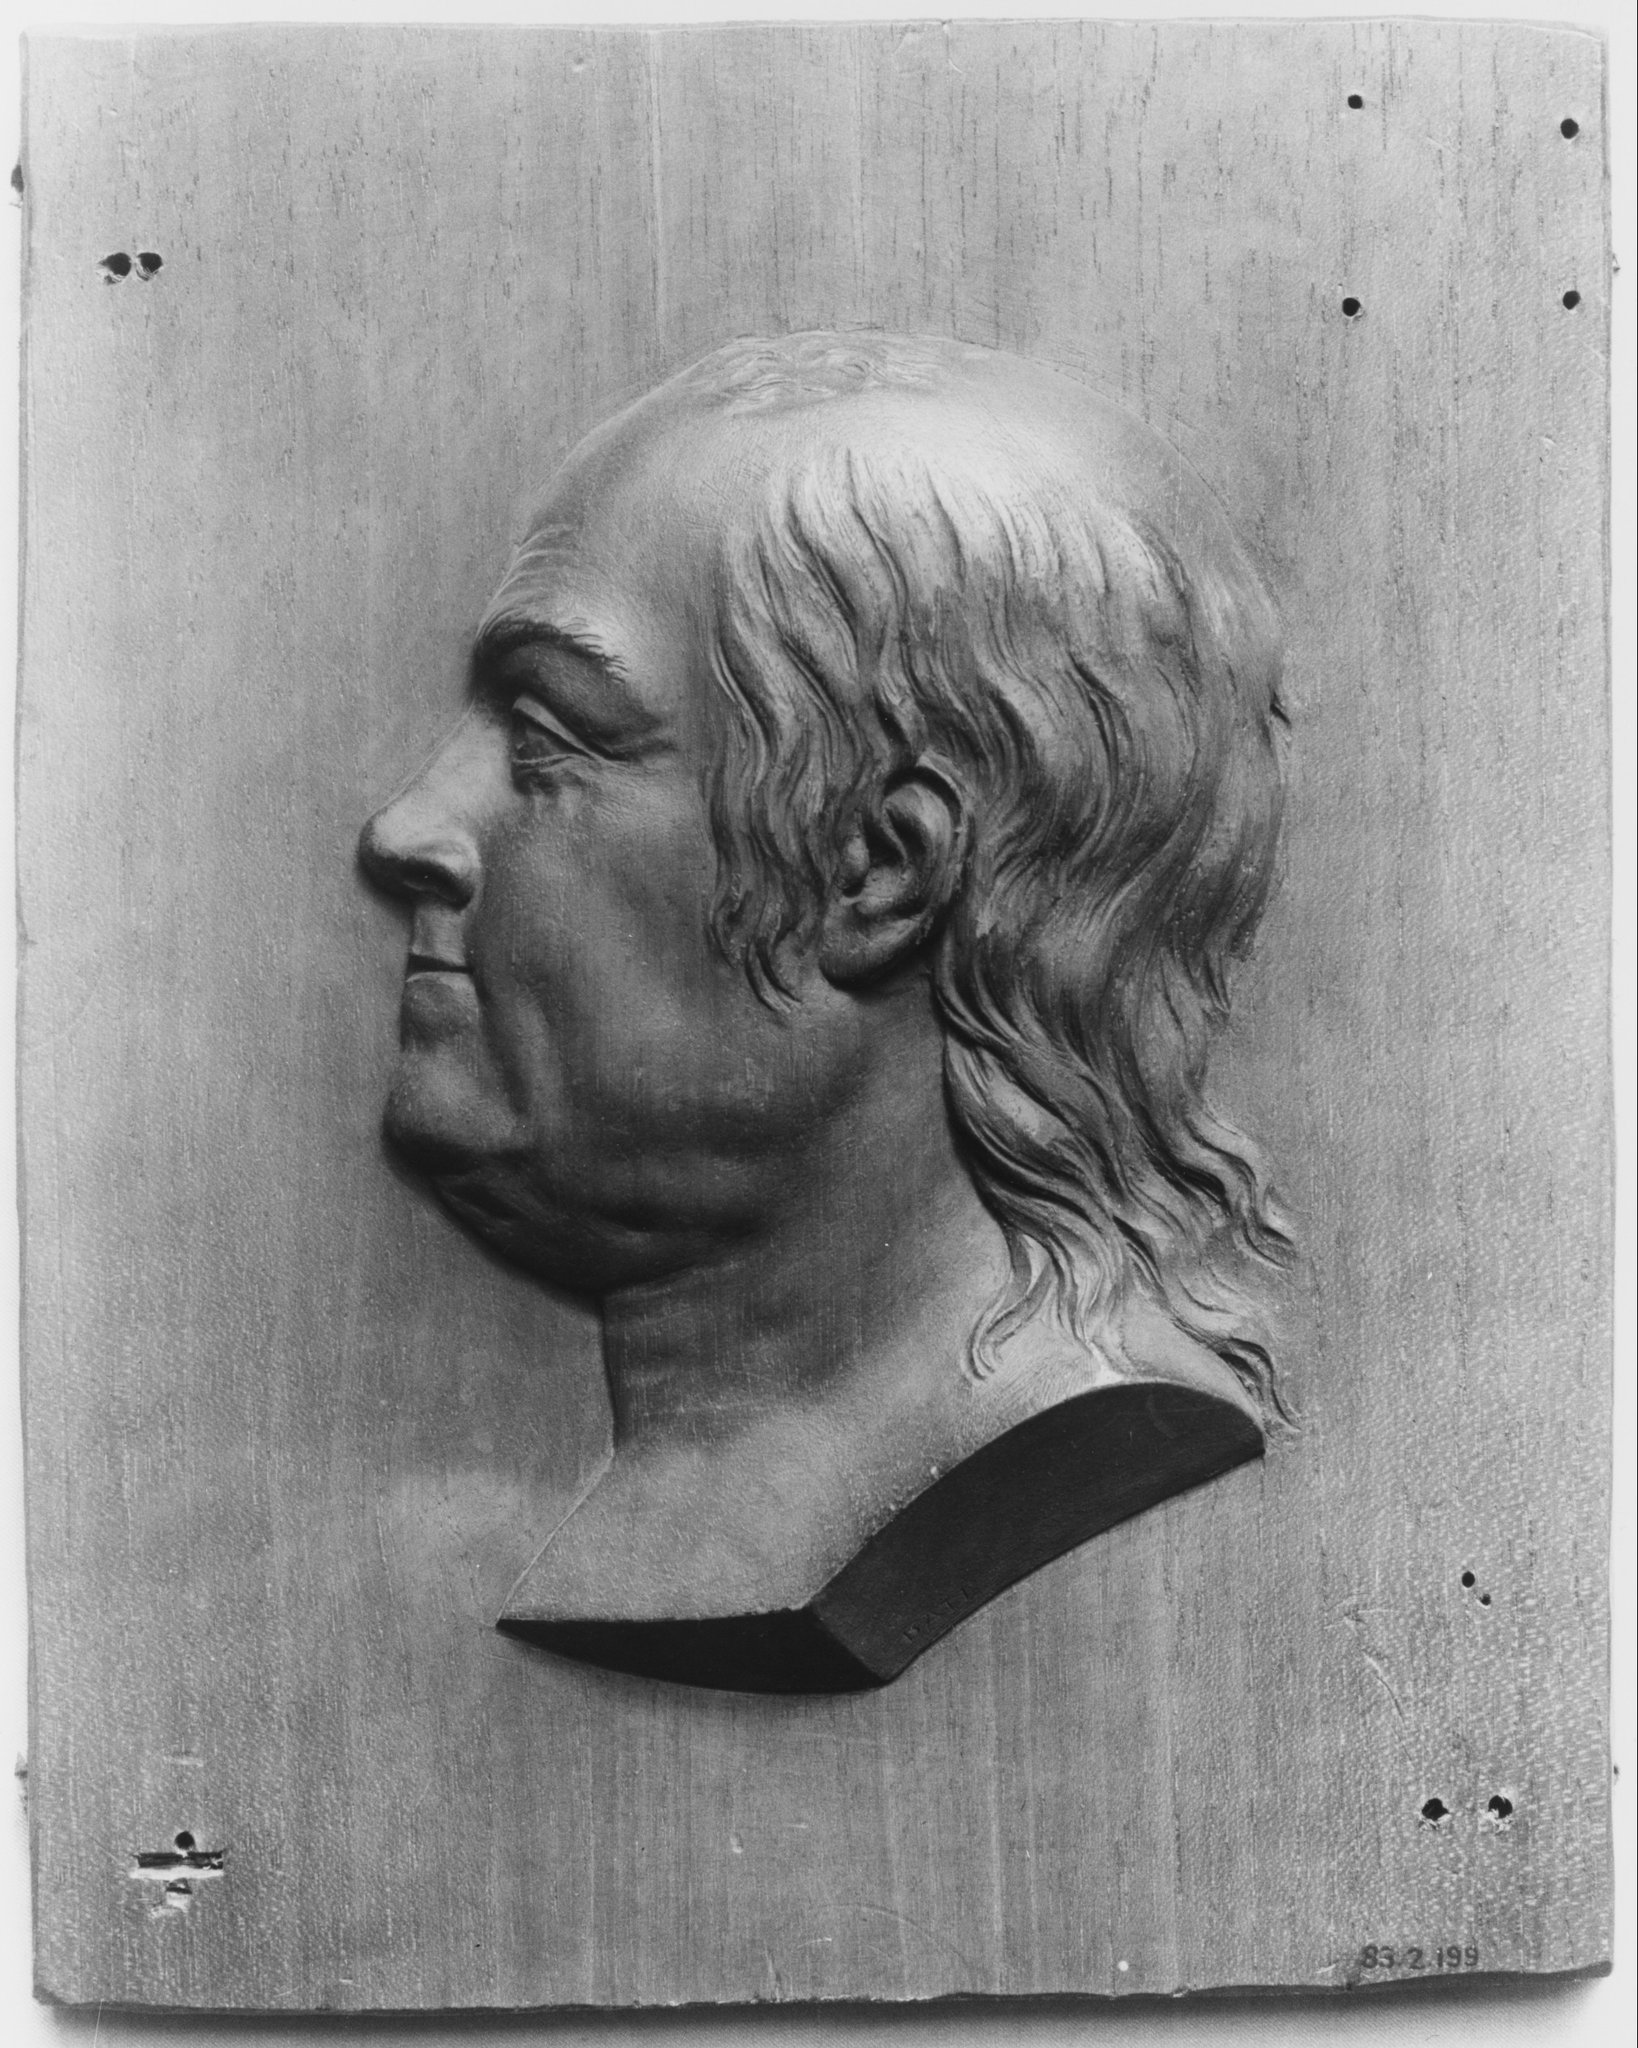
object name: bust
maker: jean-baptiste nini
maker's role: maker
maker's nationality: italian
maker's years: 1717-1786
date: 1776-1883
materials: wood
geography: italy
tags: benjamin franklin,men,portraits